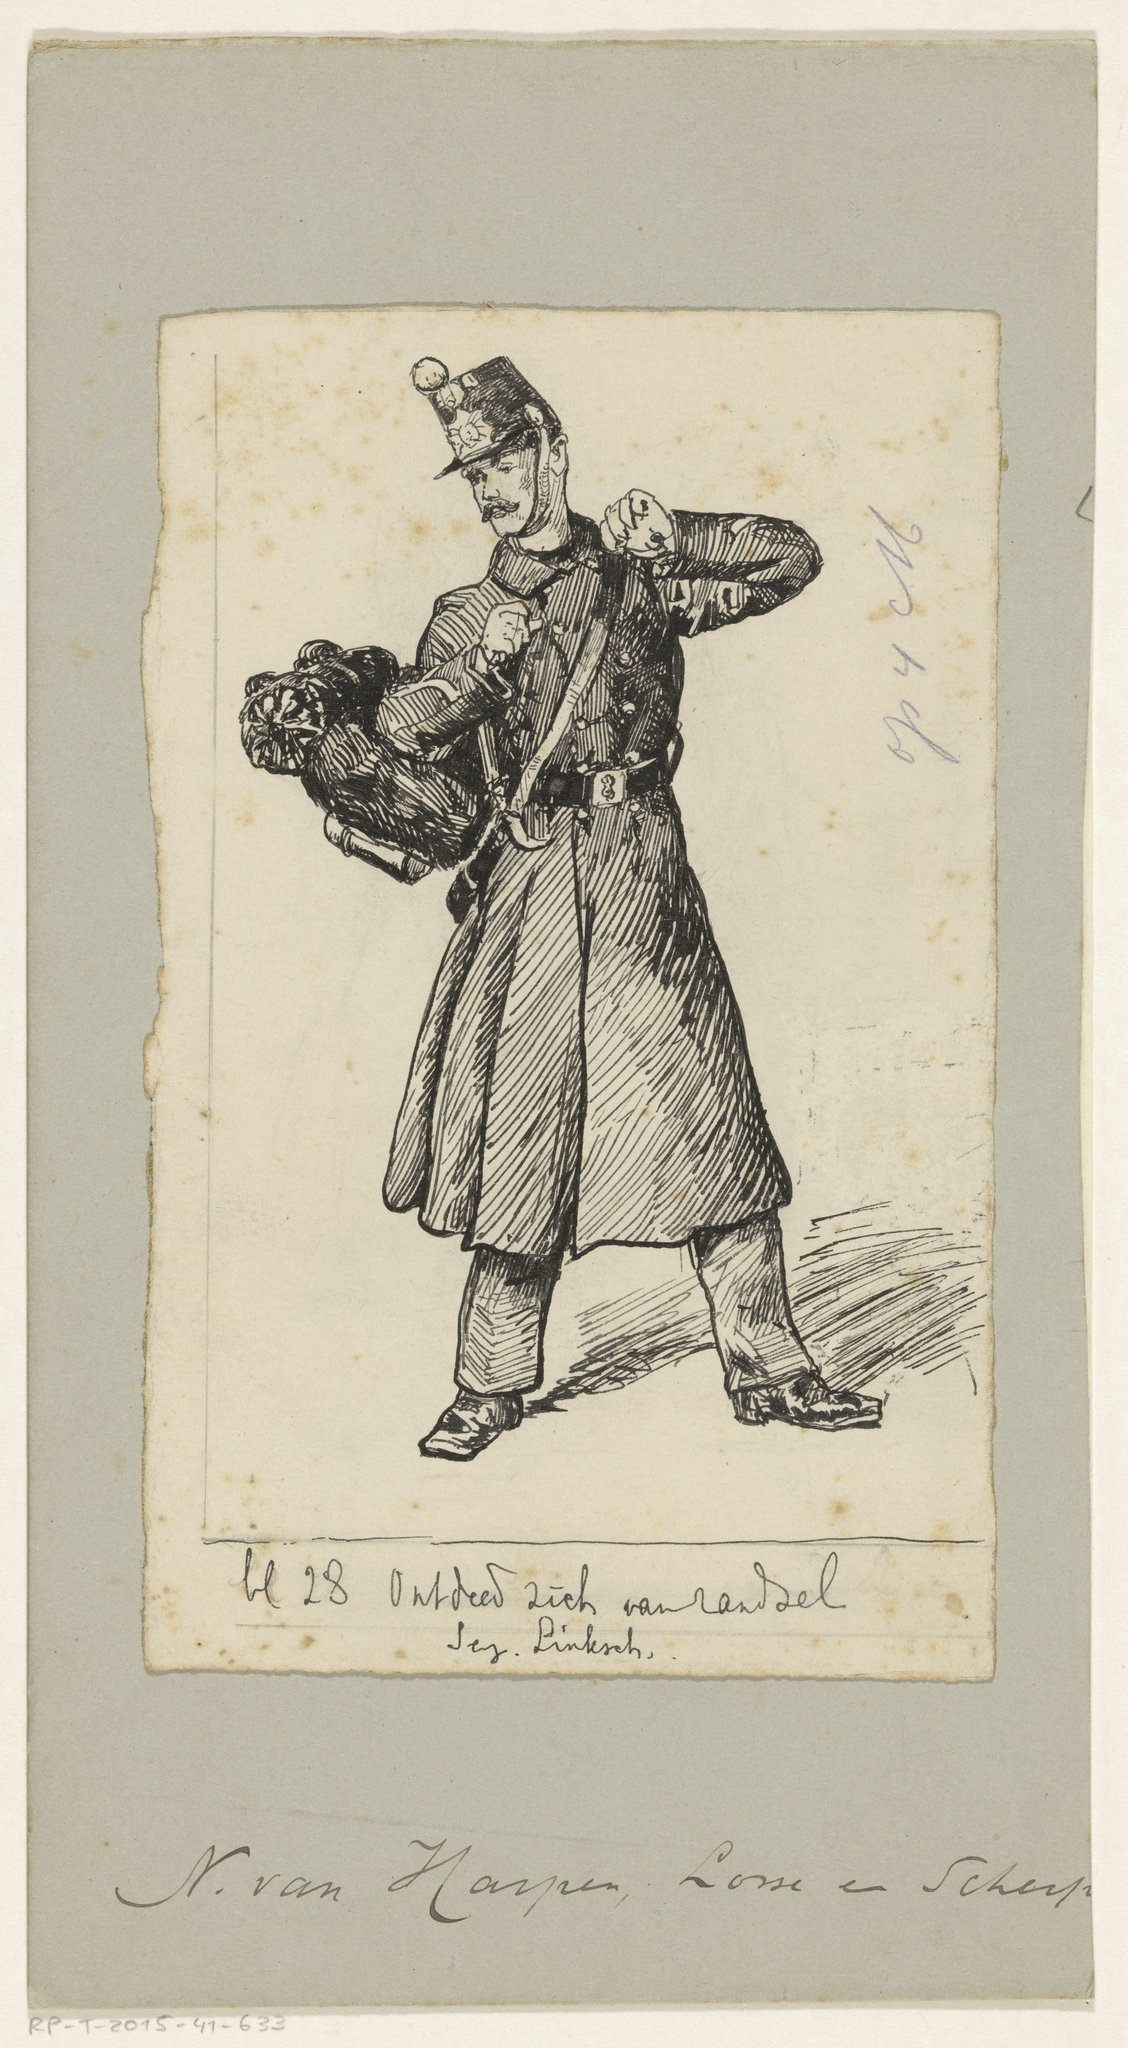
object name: drawing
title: Militair ontdoet zich van ransel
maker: jan hoynck van papendrecht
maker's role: draughtsman, painter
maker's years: 1858-1933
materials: ink, paper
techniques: pen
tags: bag, the soldier; the soldier's life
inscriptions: annotation: ‘bl 28 ontdeed zich van ransel/ Serg. Linksch.’, :, annotation: ‘N. van Harpen, Losse en Scherpe’, collector's mark: Lugt 2228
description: Ontwerp voor: Harpen, N. van. Losse en scherpe patronen. Amsterdam: Veen, 1889.